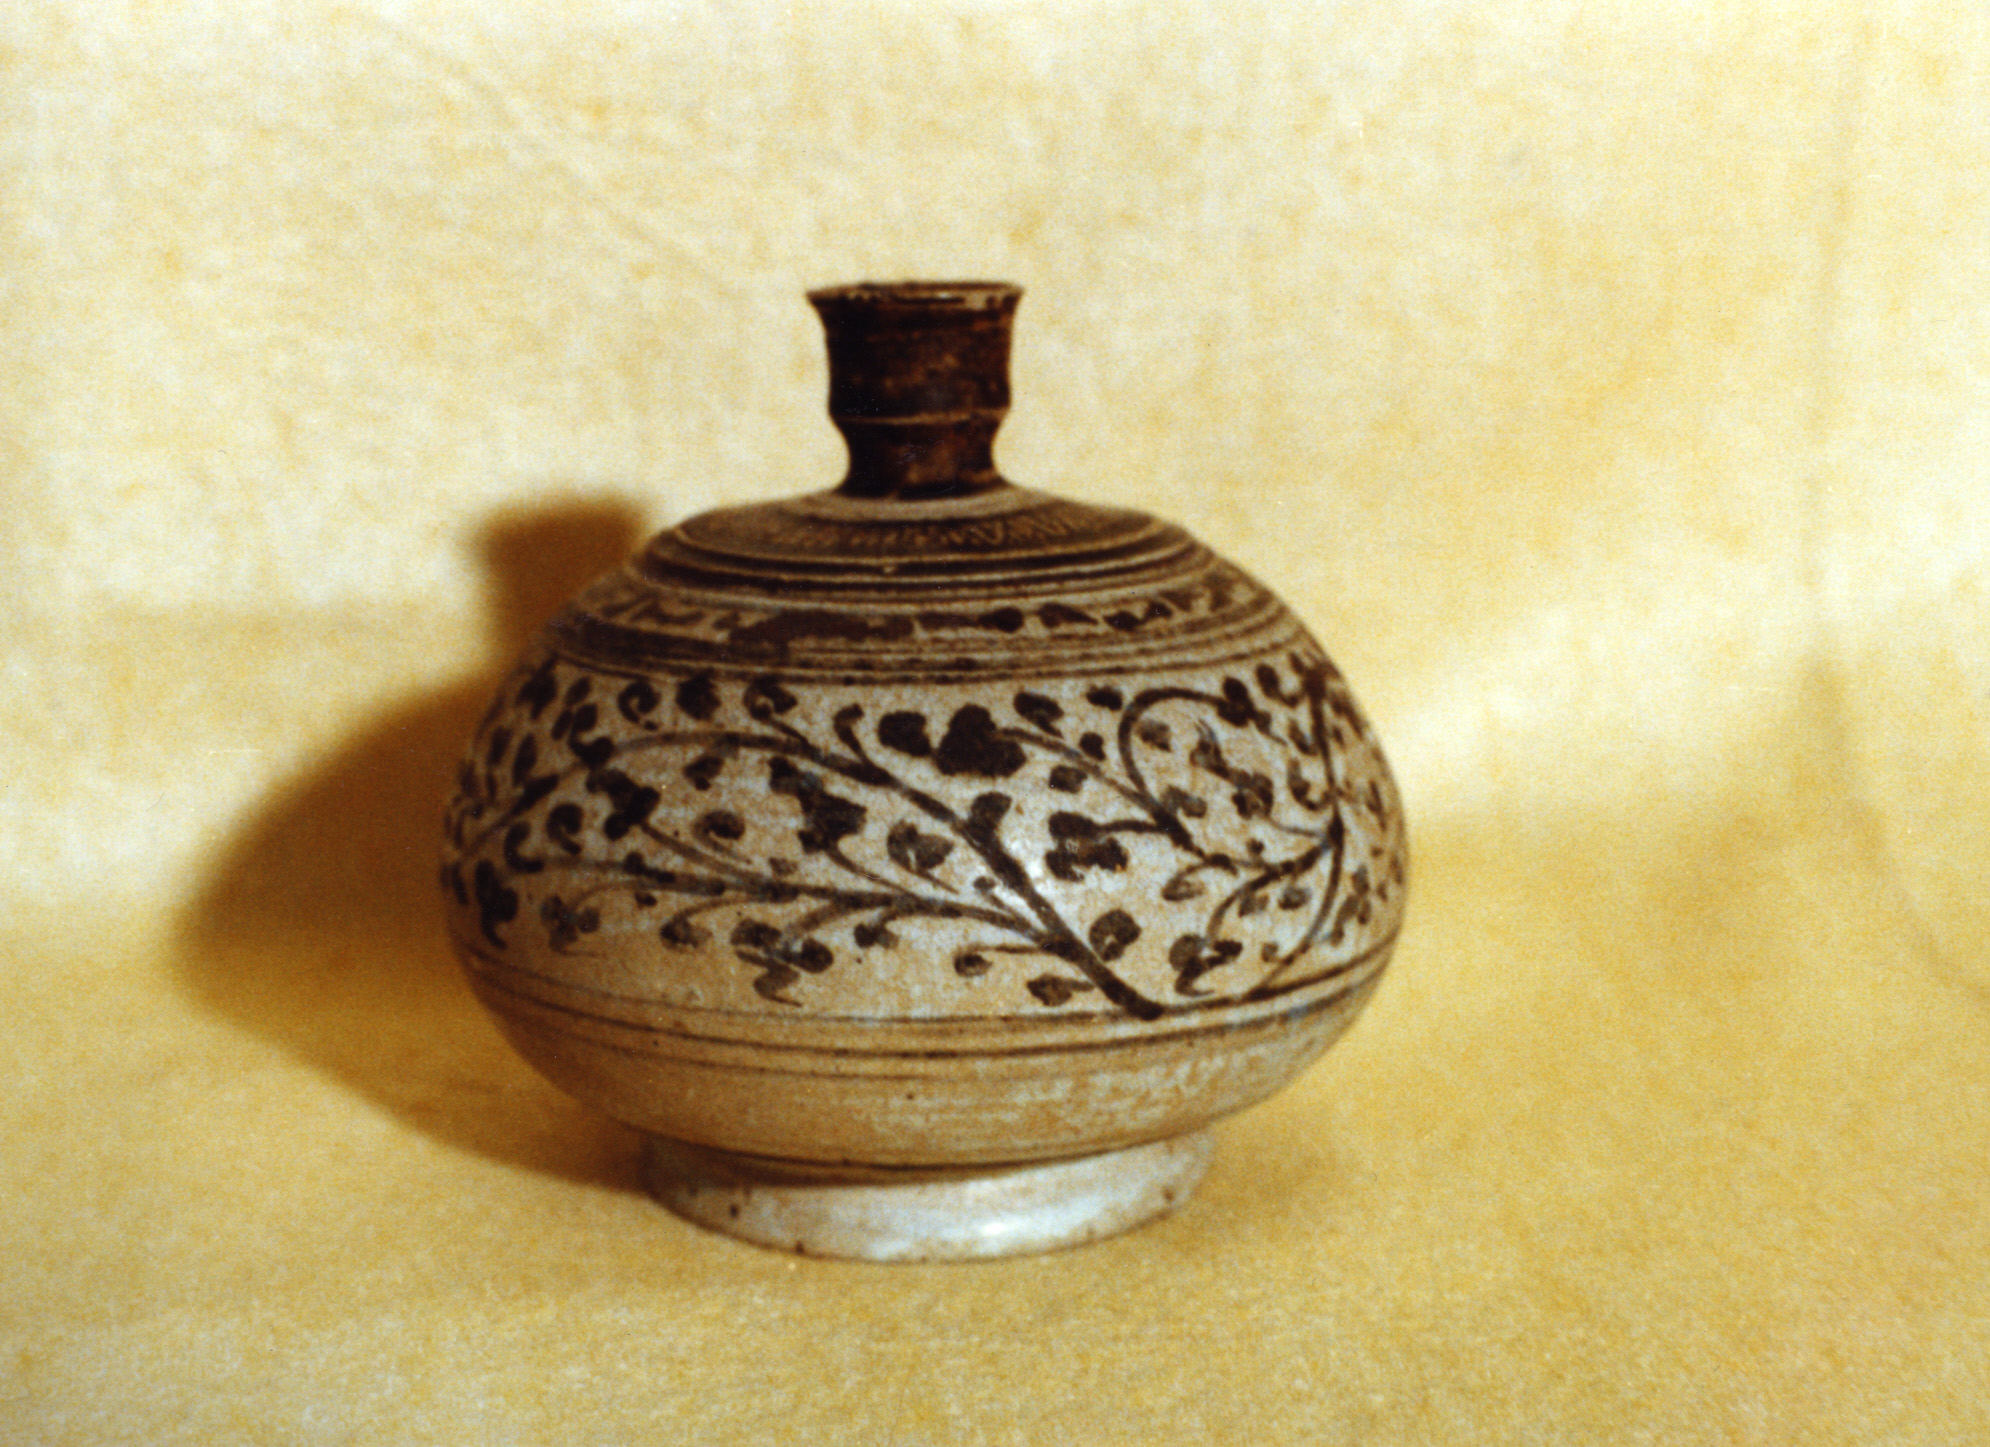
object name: jar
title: Bulbous Jar with Narrow Neck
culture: thai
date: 1401-1600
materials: earthenware, glaze, iron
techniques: underglaze